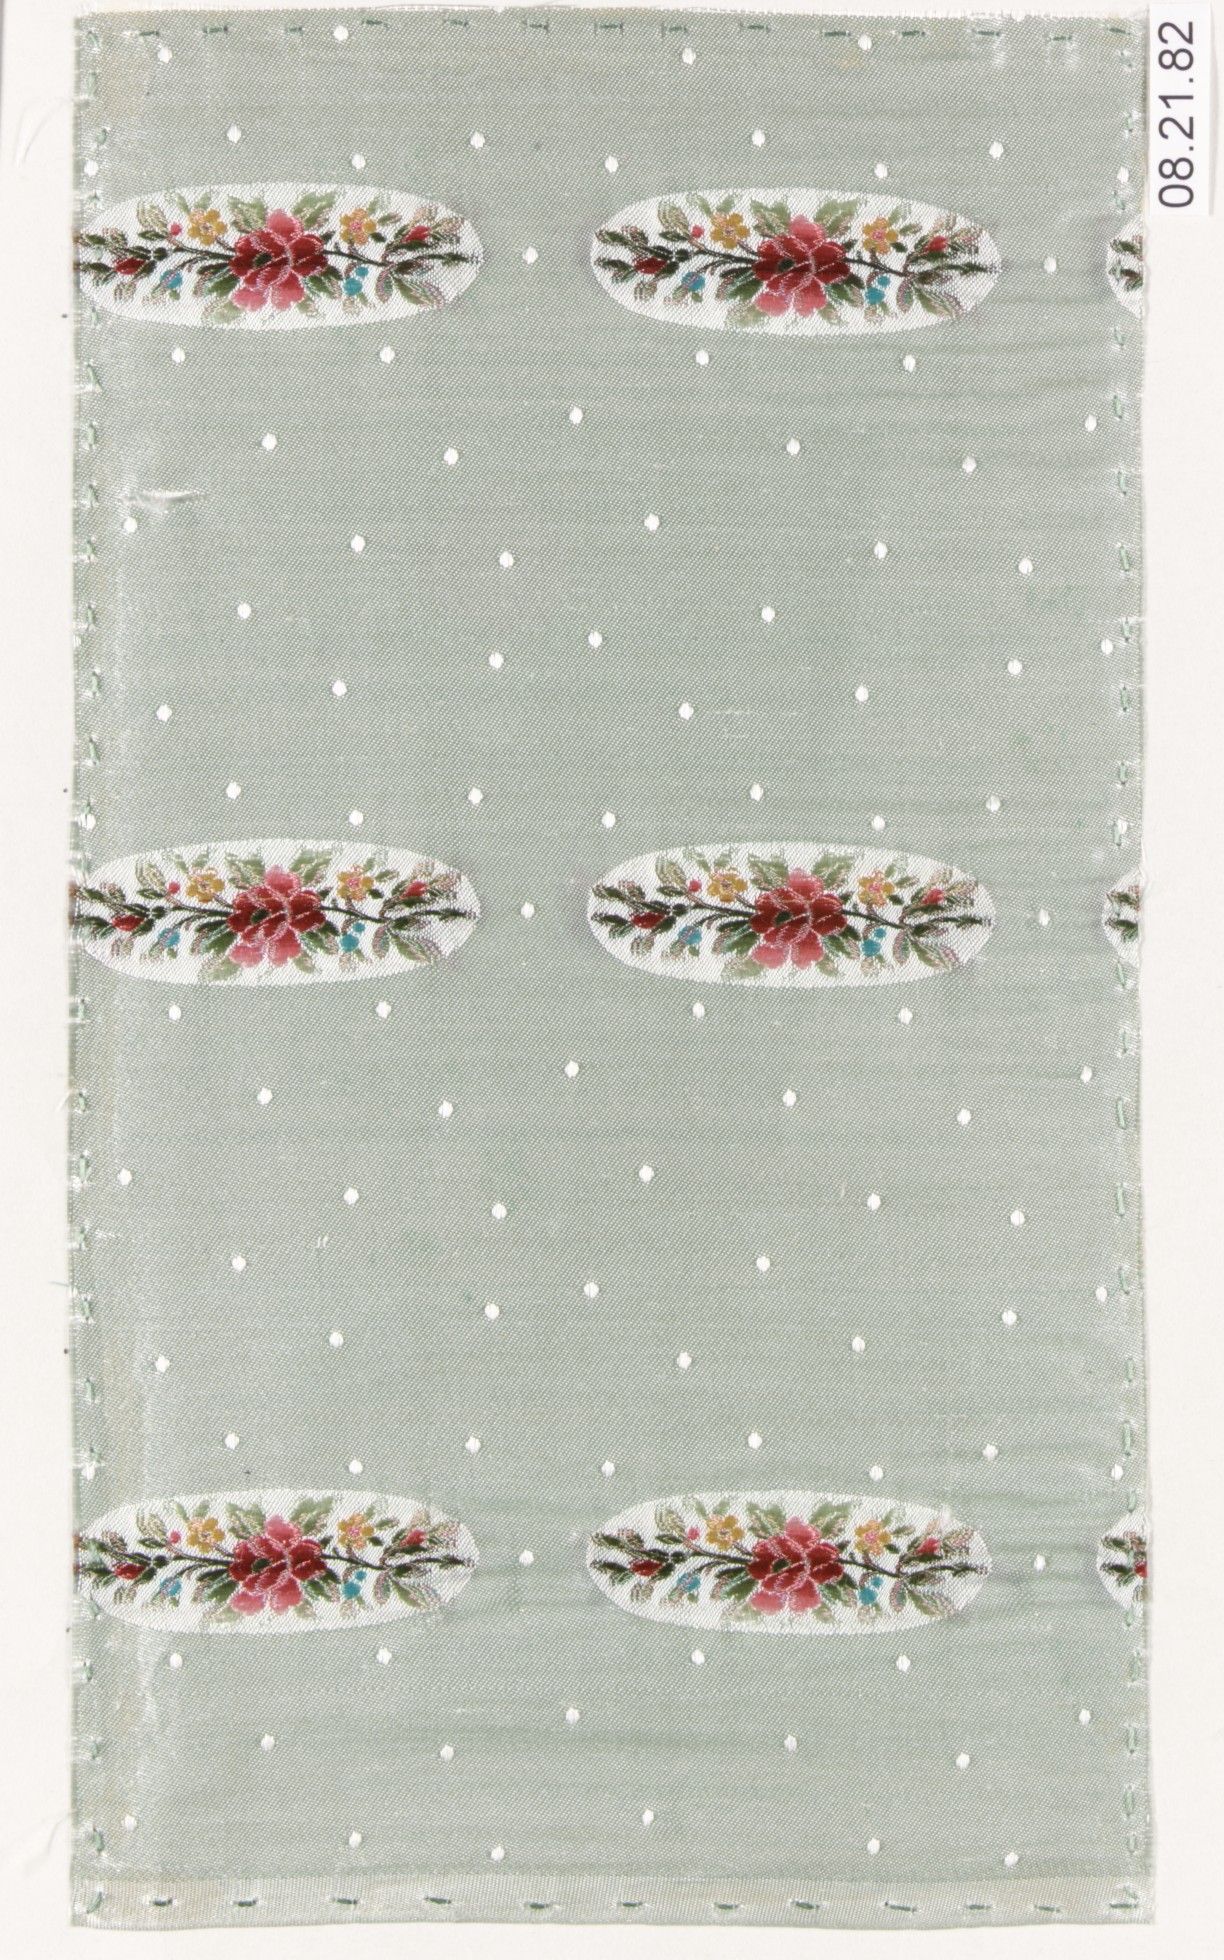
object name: textile sample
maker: Anonymous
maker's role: designer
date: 1900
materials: silk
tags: flowers